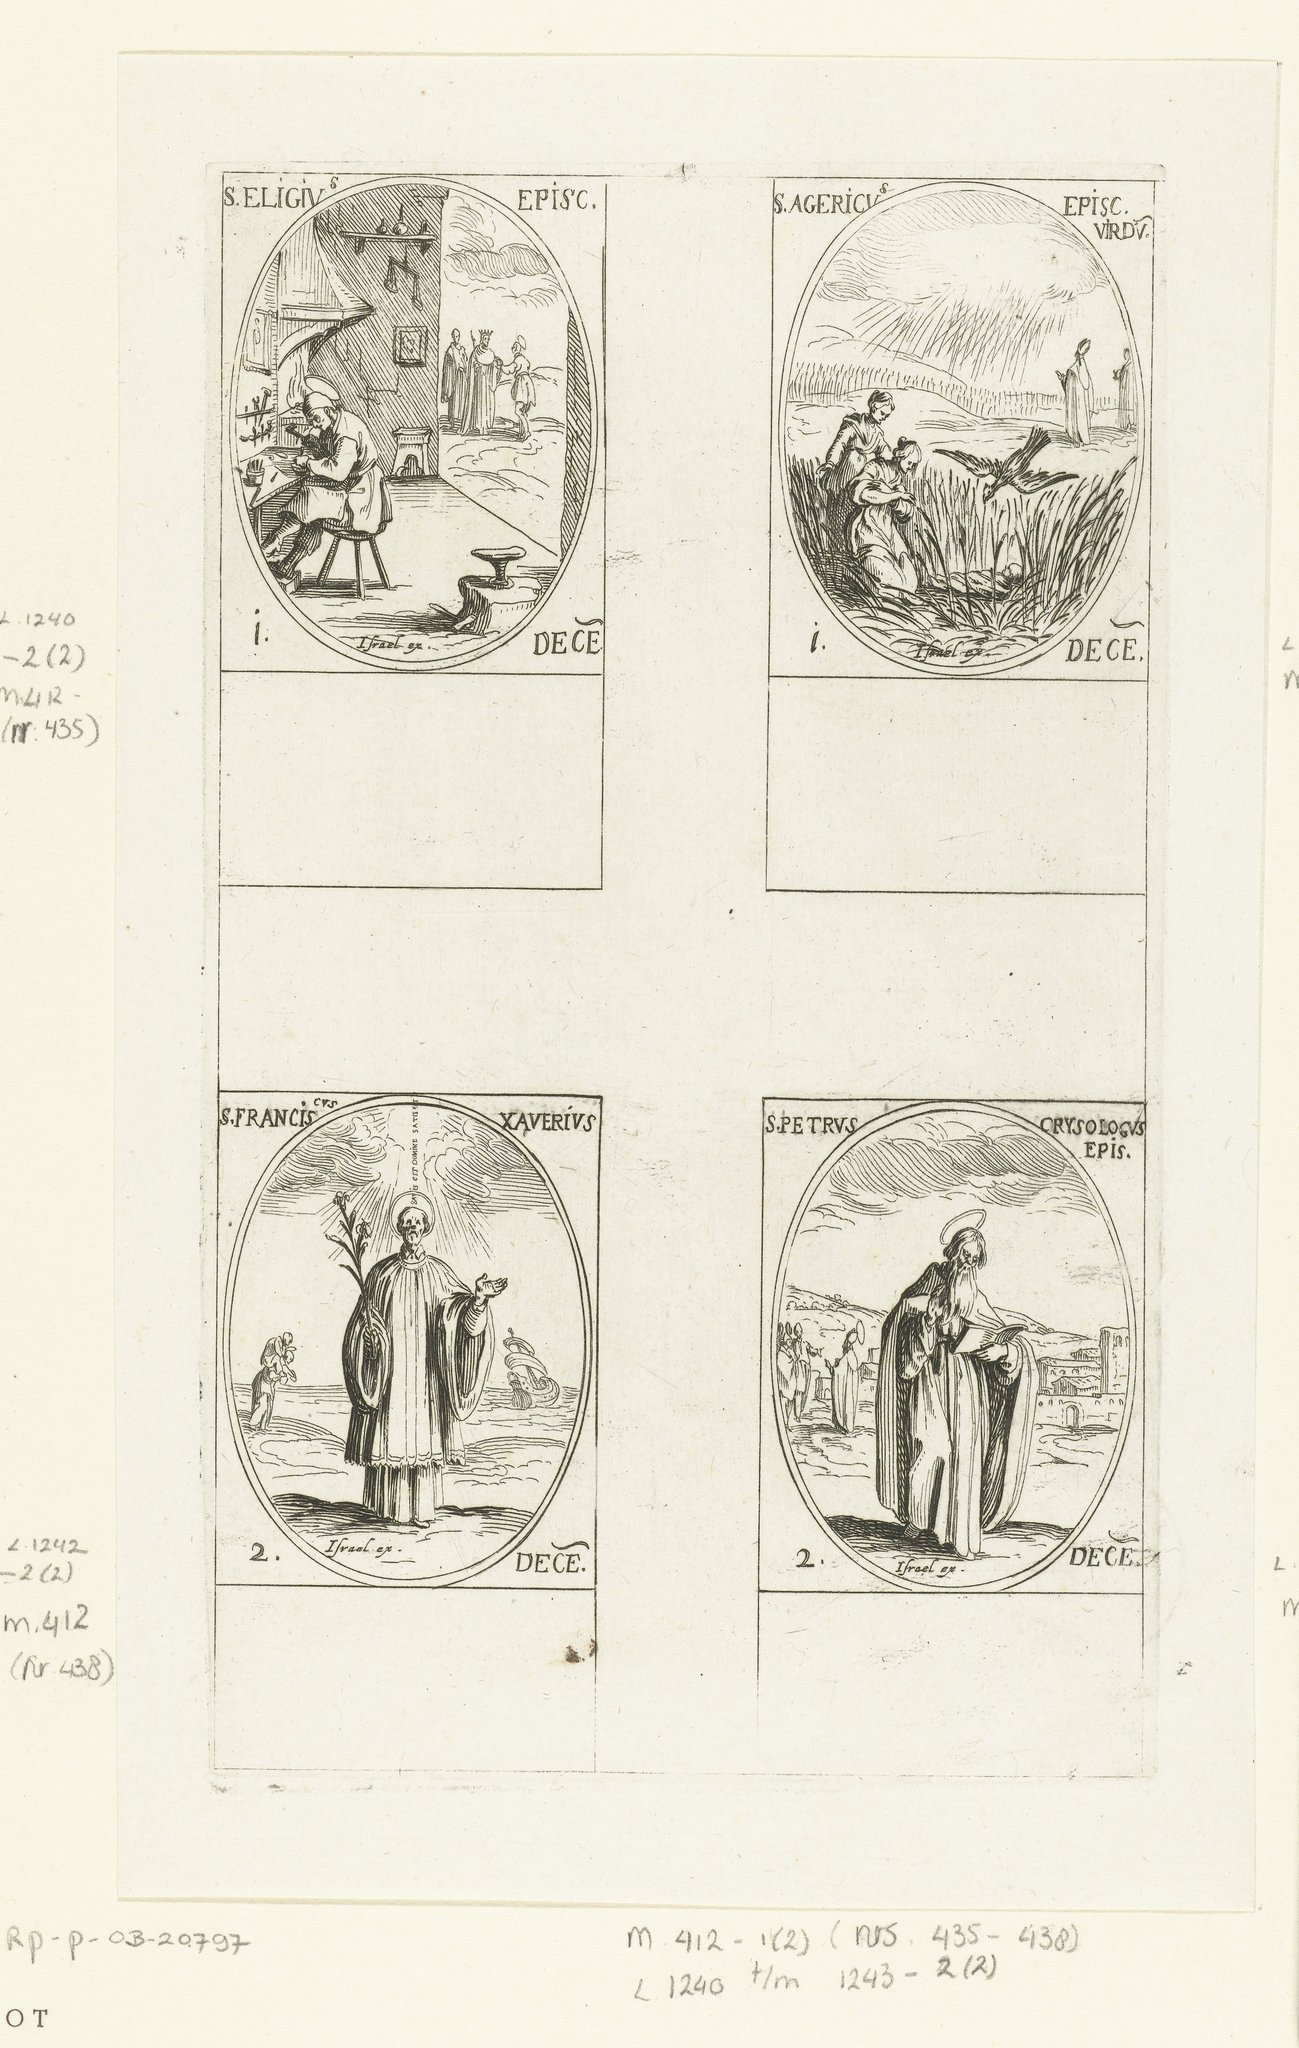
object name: print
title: Heilige Eligius van Noyon, Heilige Agericus van Verdun, Heilige Franciscus Xaverius, Heilige Petrus Chrysologus (1-2 december)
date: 1632-1636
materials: paper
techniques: etching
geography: paris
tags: the blacksmith and goldsmith eloi (eligius), bishop of noyon; possible attributes: anvil, cup, (crown on) hammer, horse (missing one leg), horseleg, horseshoe, tongs, male saints (with name), the jesuit missionary francis xavier; possible attributes: cross, crucifix, flaming heart, indian, lily, torch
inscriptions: collector's mark: Lugt 240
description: Blad met vier ovale voorstellingen, elk met opschrift en datum in het Latijn: linksboven de Heilige Eligius van Noyon aan het werk in zijn smidse, rechtsboven twee vrouwen bij een baby en een vogel in een veld met op de achtergrond de Heilige Agericus van Verdun, linksonder de Heilige Franciscus Xaverius met een lelie in de hand, rechtsonder de Heilige Petrus Chrysologus lezend in een boek. Deze prent is onderdeel van een serie prenten met voorstellingen van de heiligen en de christelijke feestdagen van het jaar. Er zijn steeds vier scènes van één plaat op één blad gedrukt. Inclusief bijbehorend titelblad en frontispice gaat het in totaal om 124 platen (490 voorstellingen). De drie platen met de laatste 12 scènes (de veranderlijke christelijke feestdagen) zijn in de derde staat versneden tot 12 kleine plaatjes, en met een apart titelblad uitgegeven.